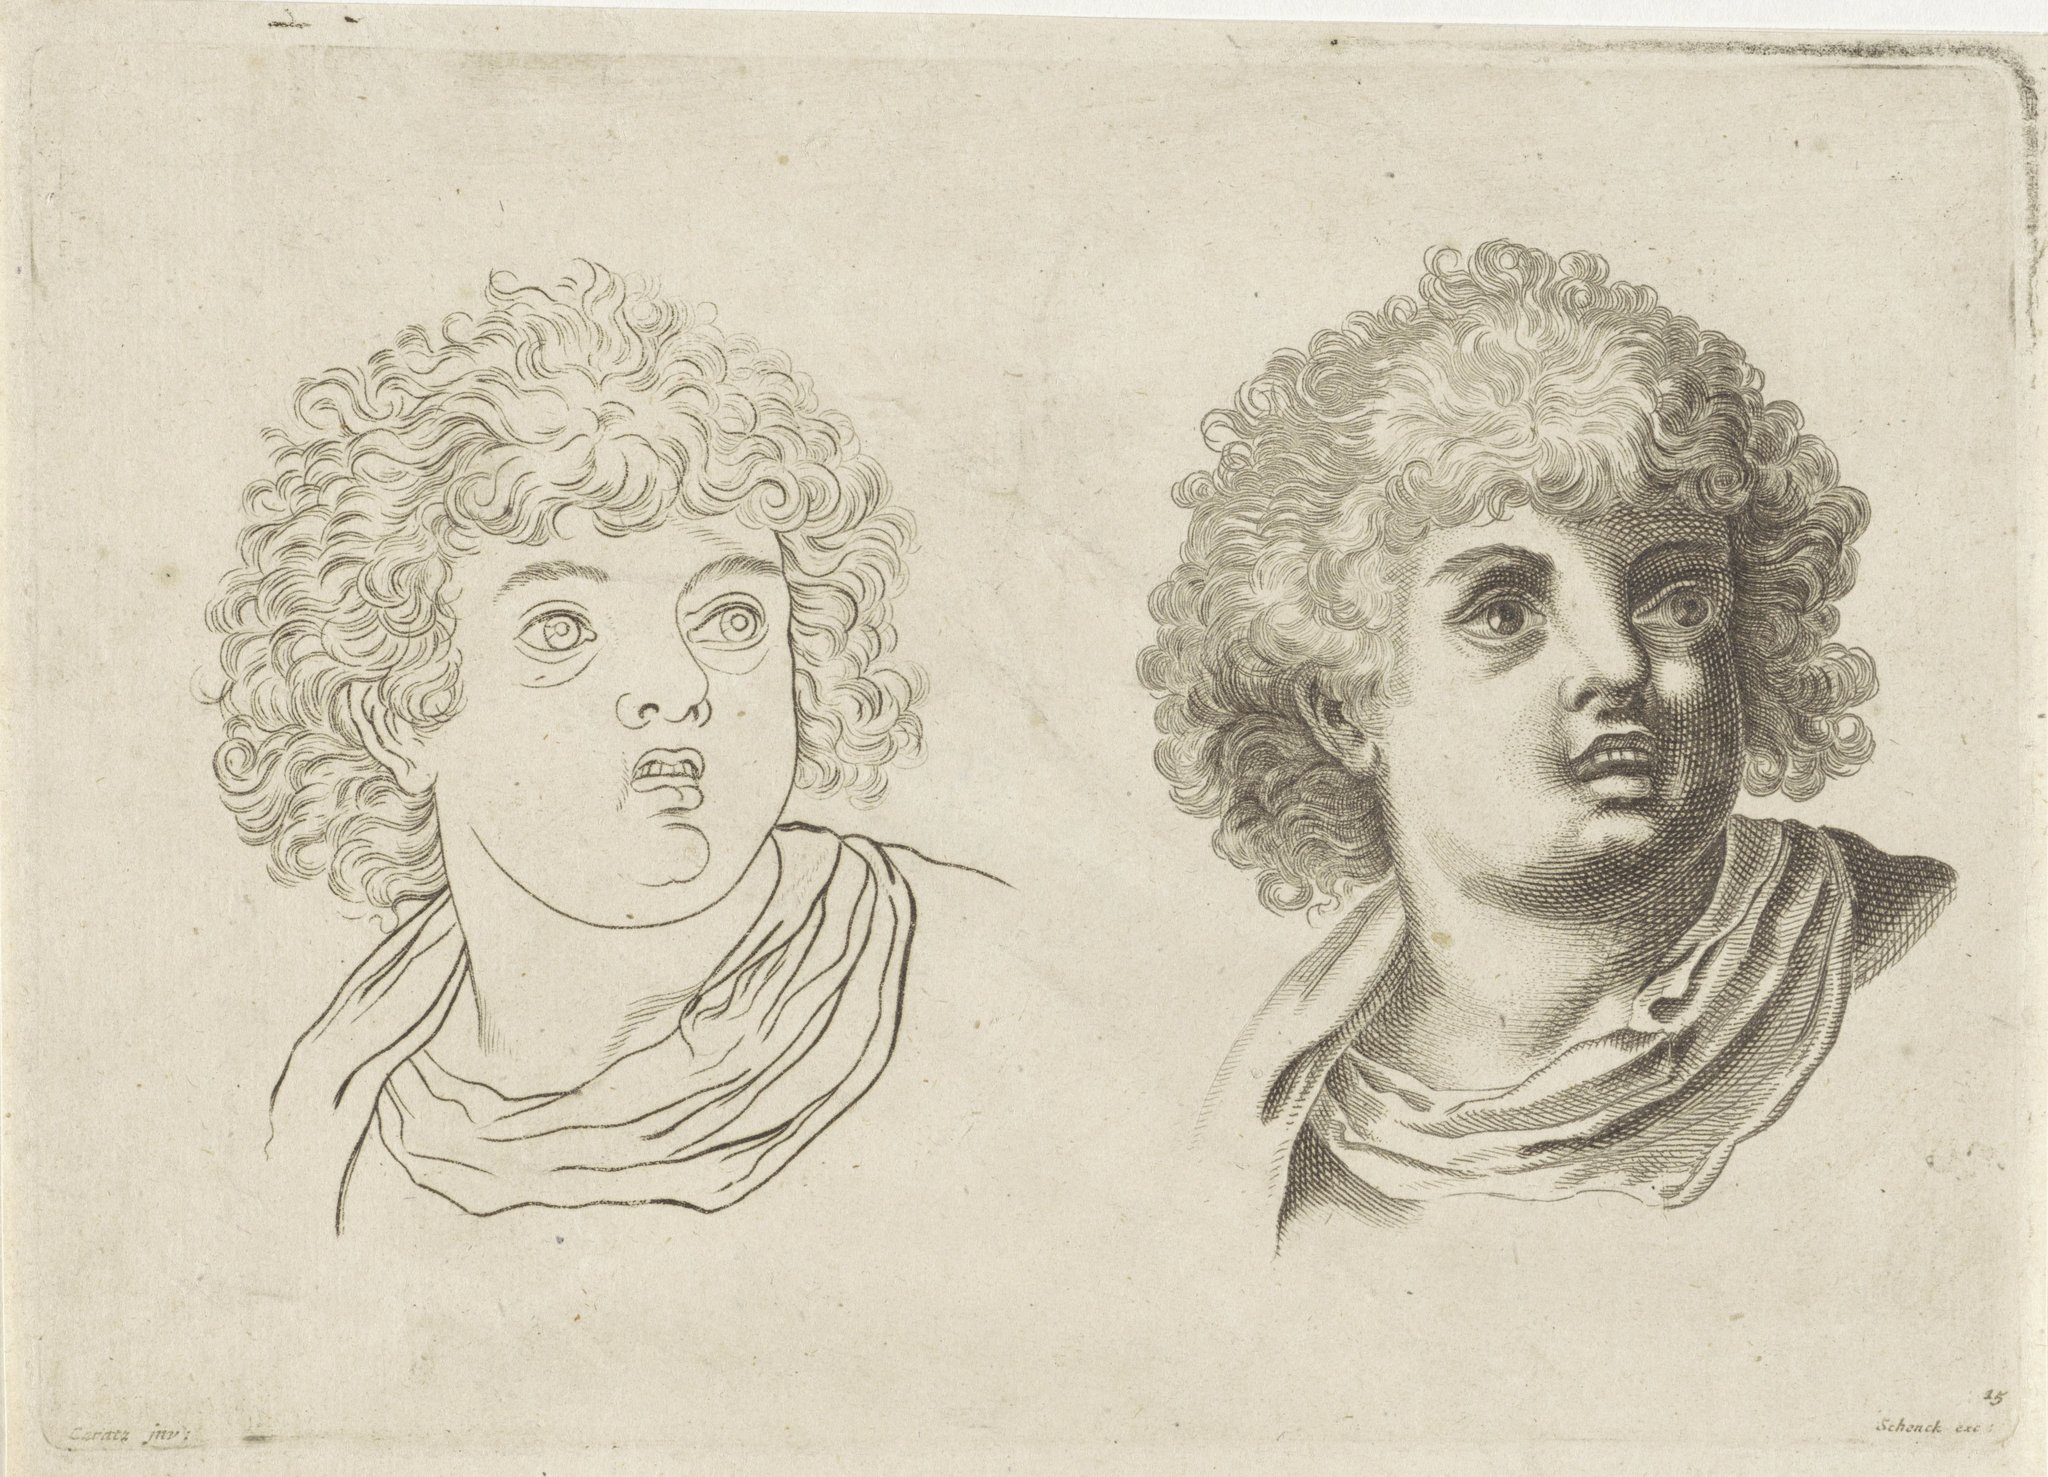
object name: print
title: Figuren naar Annibale Carracci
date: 1675-1711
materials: paper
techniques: engraving, etching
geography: amsterdam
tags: child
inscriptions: collector's mark: Lugt 2228